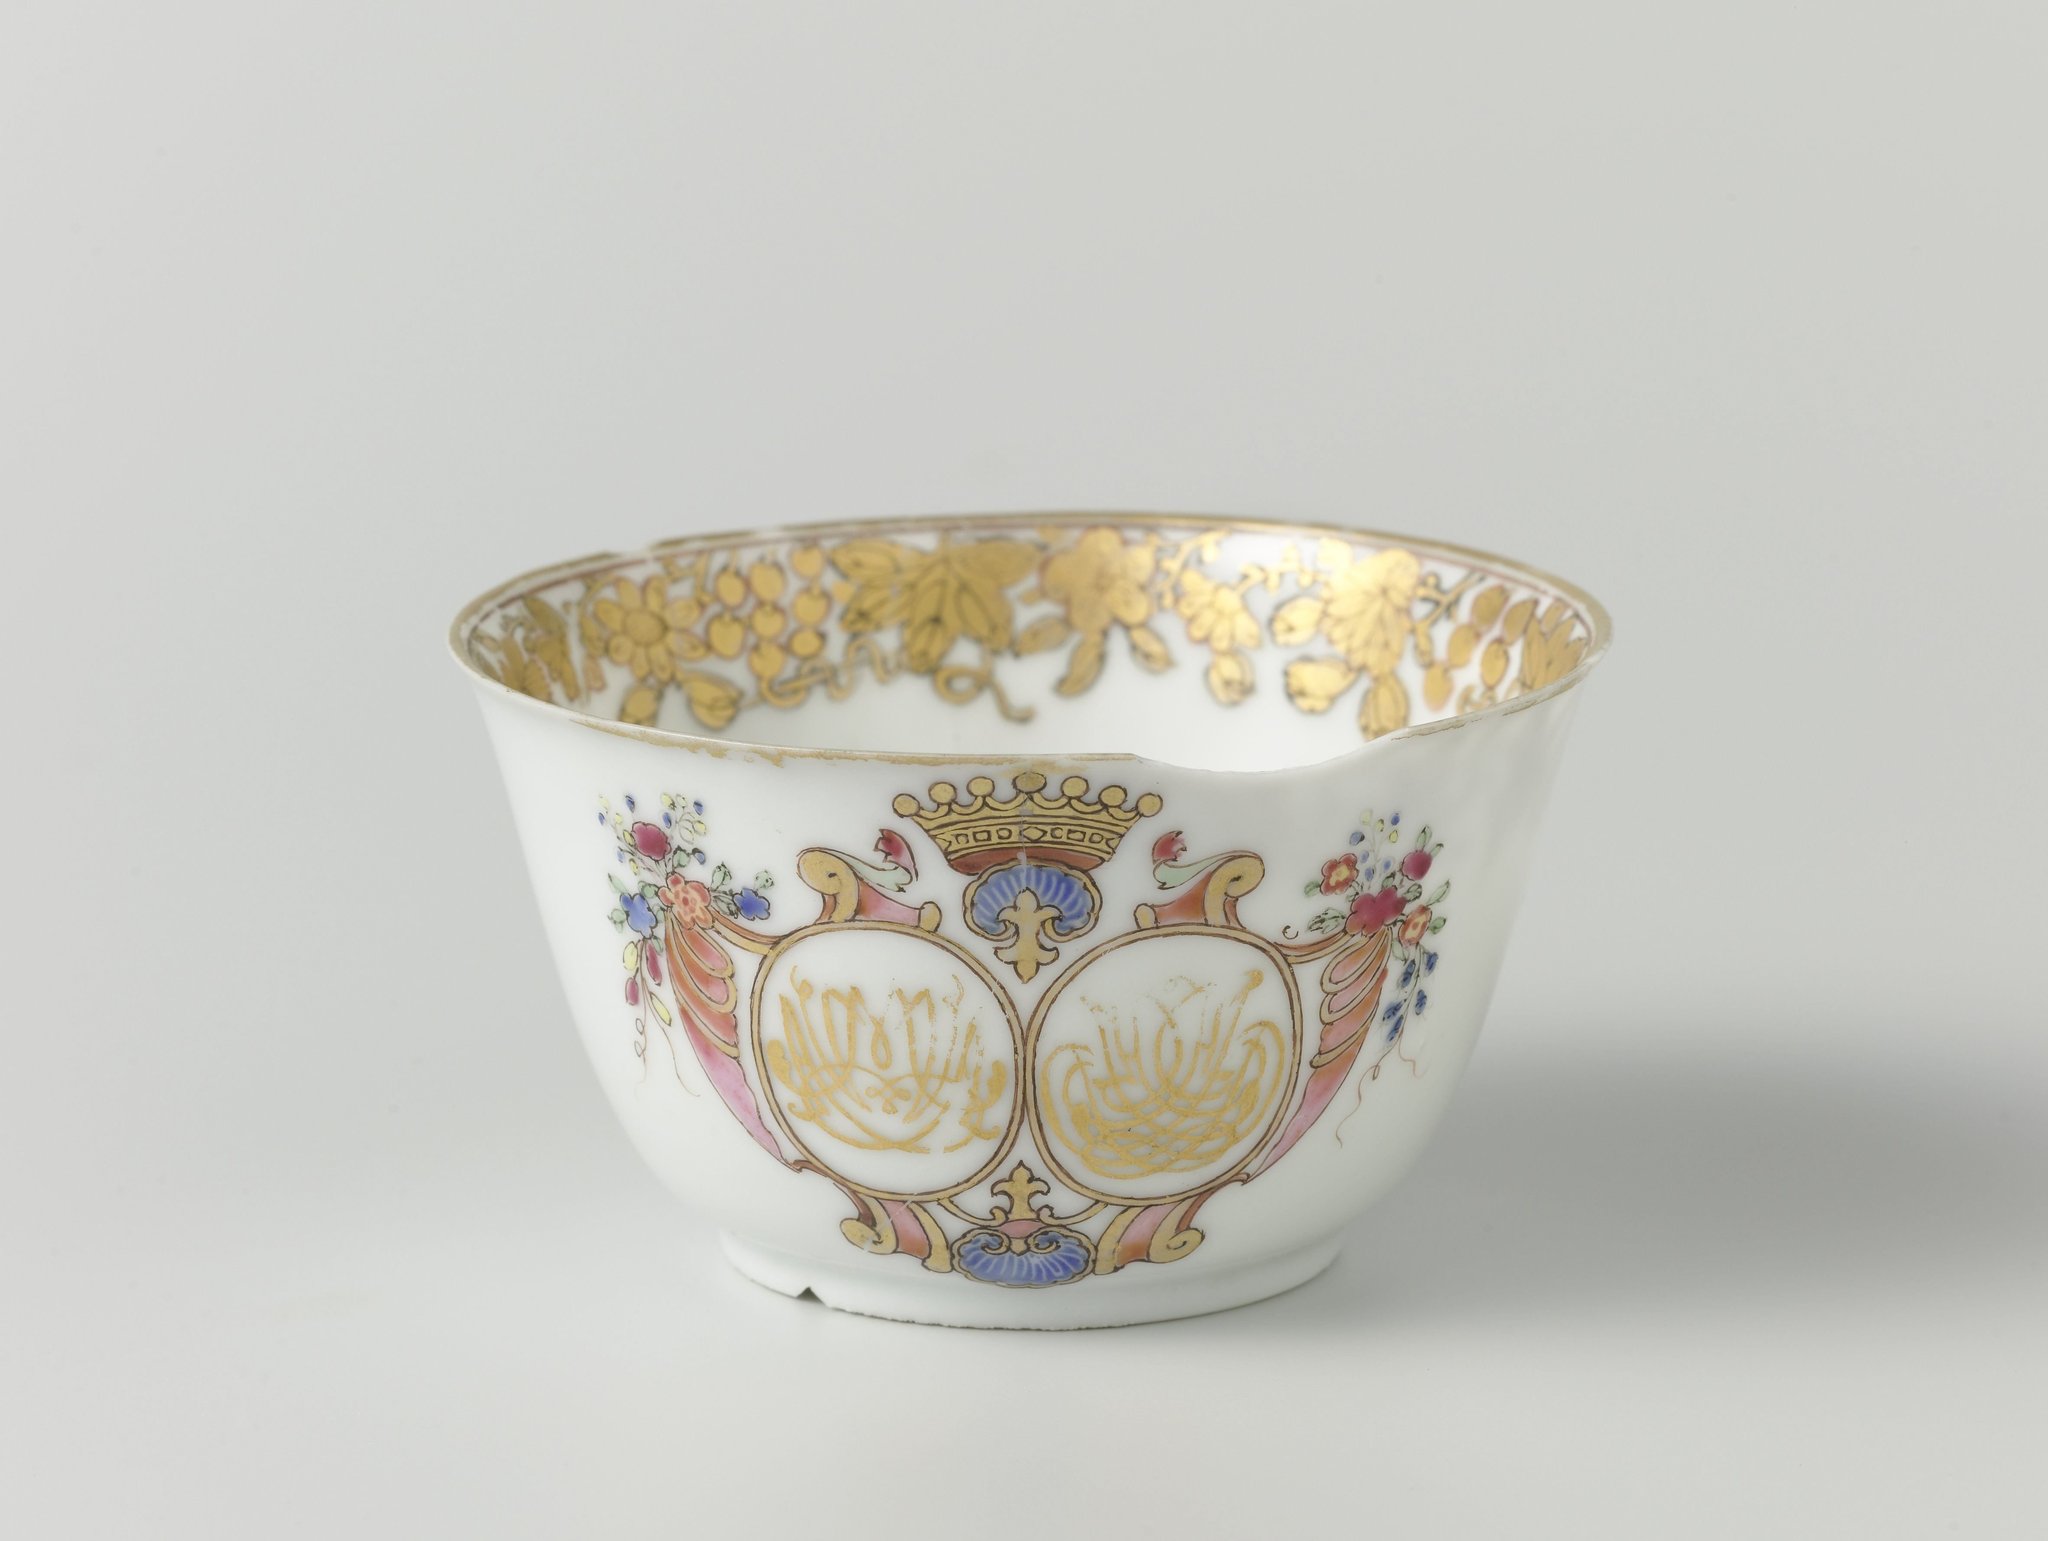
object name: tea cup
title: Bell-shaped cup from the 'Swellengrebel service' with a double crowned monogram and a border with floral scrolls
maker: Anonymous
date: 1740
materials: glaze, gold, paint, porcelain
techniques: firing, gilding, turning, vitrification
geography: china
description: De monogrammen 'MVA' en 'CHTD' staan voor Maurits van Aerden (1694-1746) en Constantia Helena ten Damme (1694-1772), getrouwd in 1716. Het servies is waarschijnlijk besteld ter ere van hun vijfentwingtigjarig huwelijksjubileum in 1741. (Campen, Jan van & Hartkamp-Jonxis, Ebeltje, Aziatische weelde : VOC-kunst in het Rijksmuseum, Zutphen 2011, p. 78)